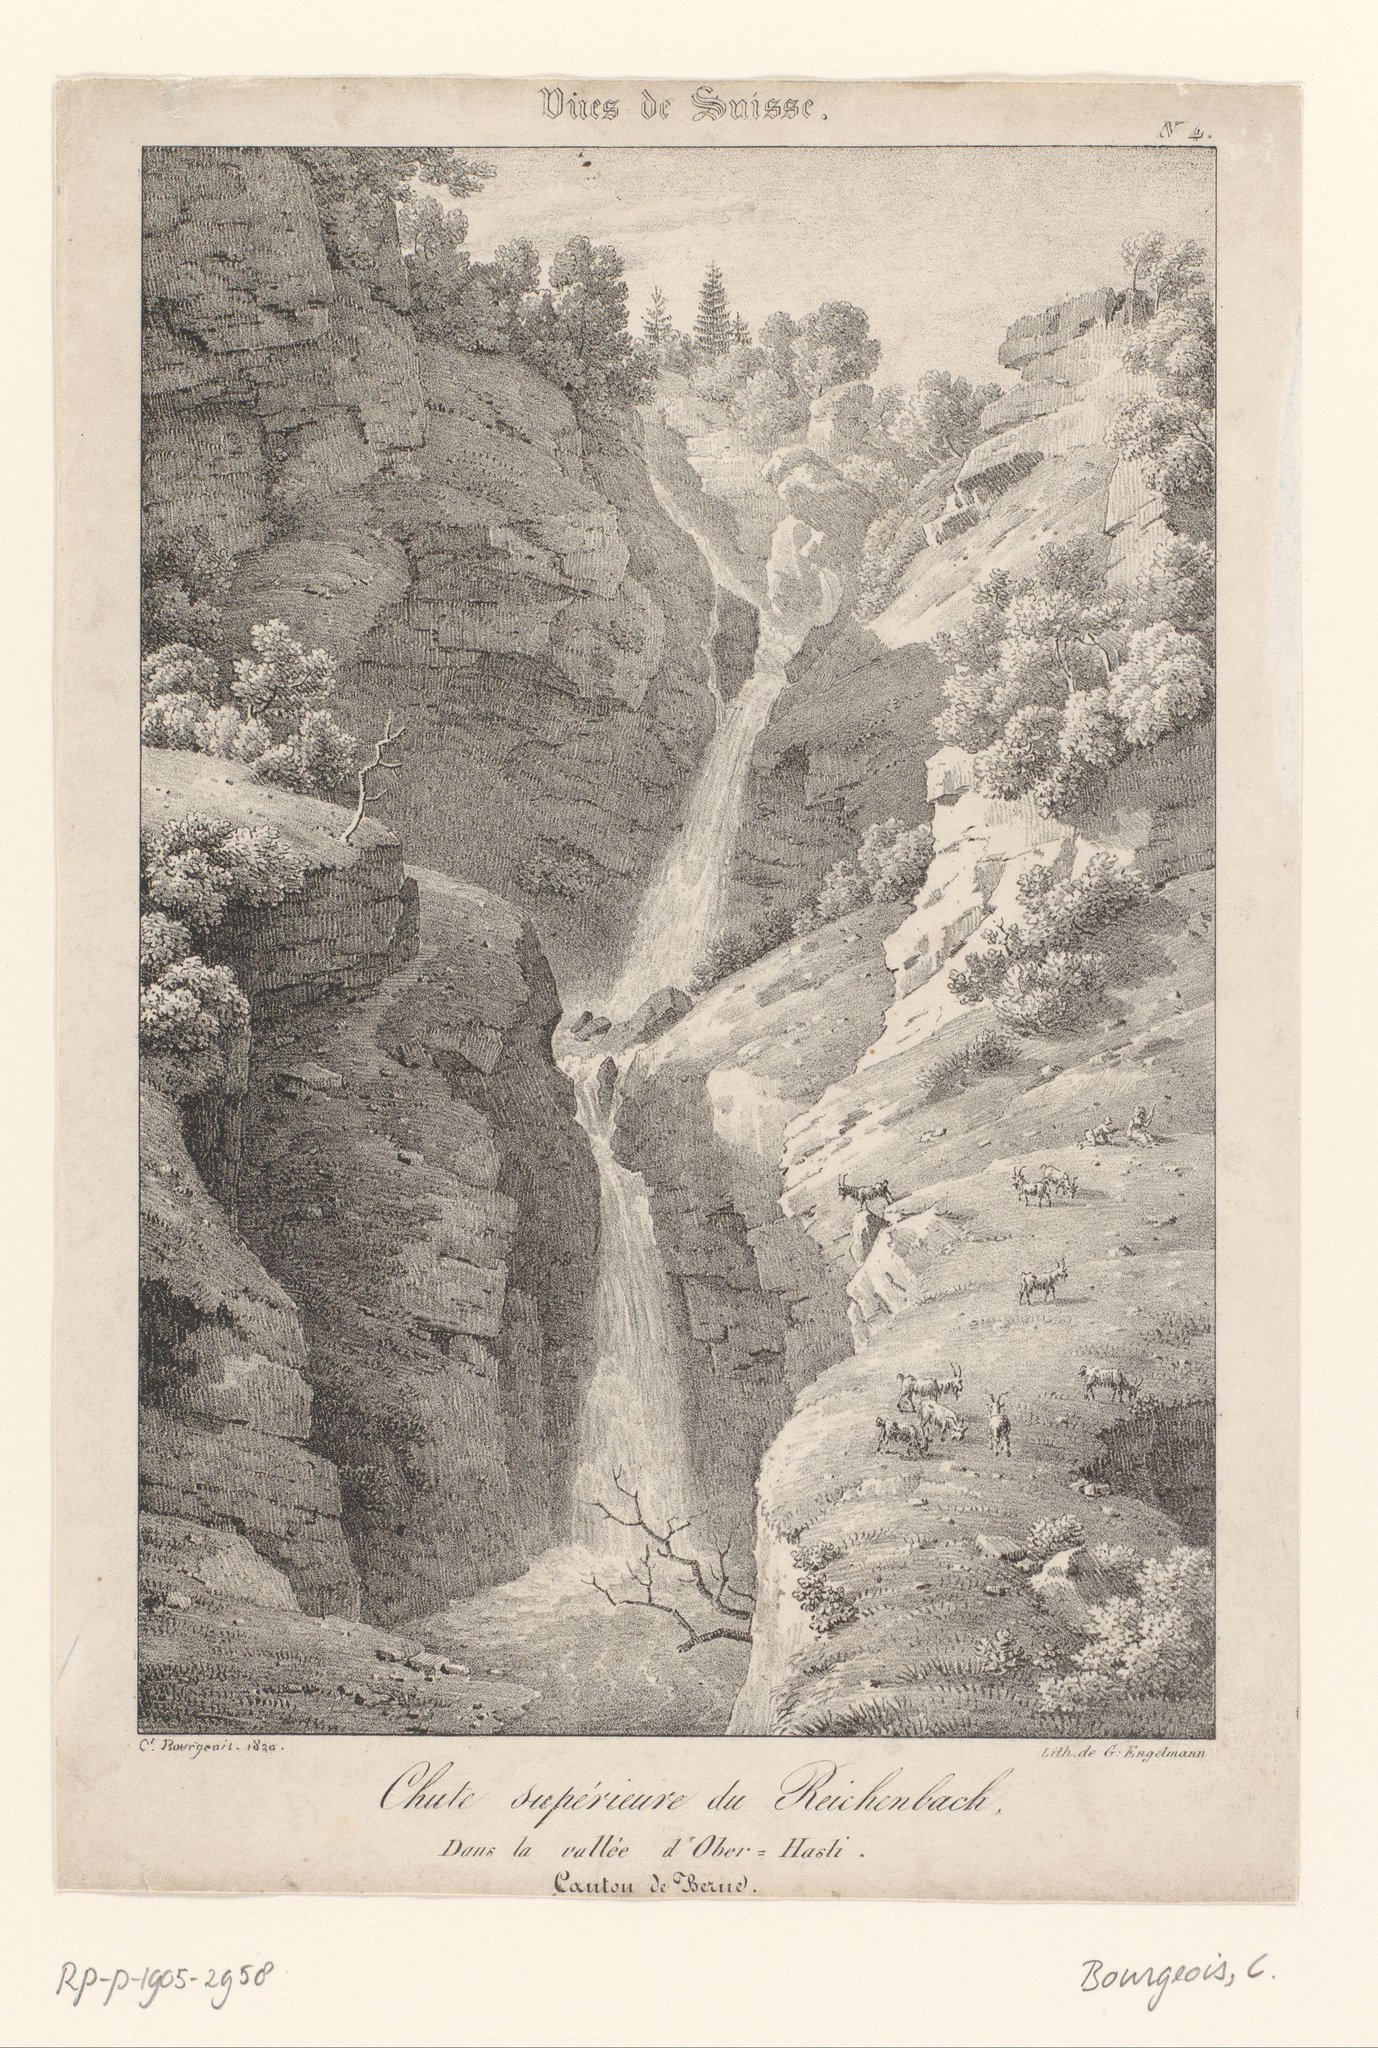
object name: print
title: Zicht op de Reichenbachwaterval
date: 1820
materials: paper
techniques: lithograph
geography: paris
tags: waterfall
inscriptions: collector's mark: Lugt 2228a